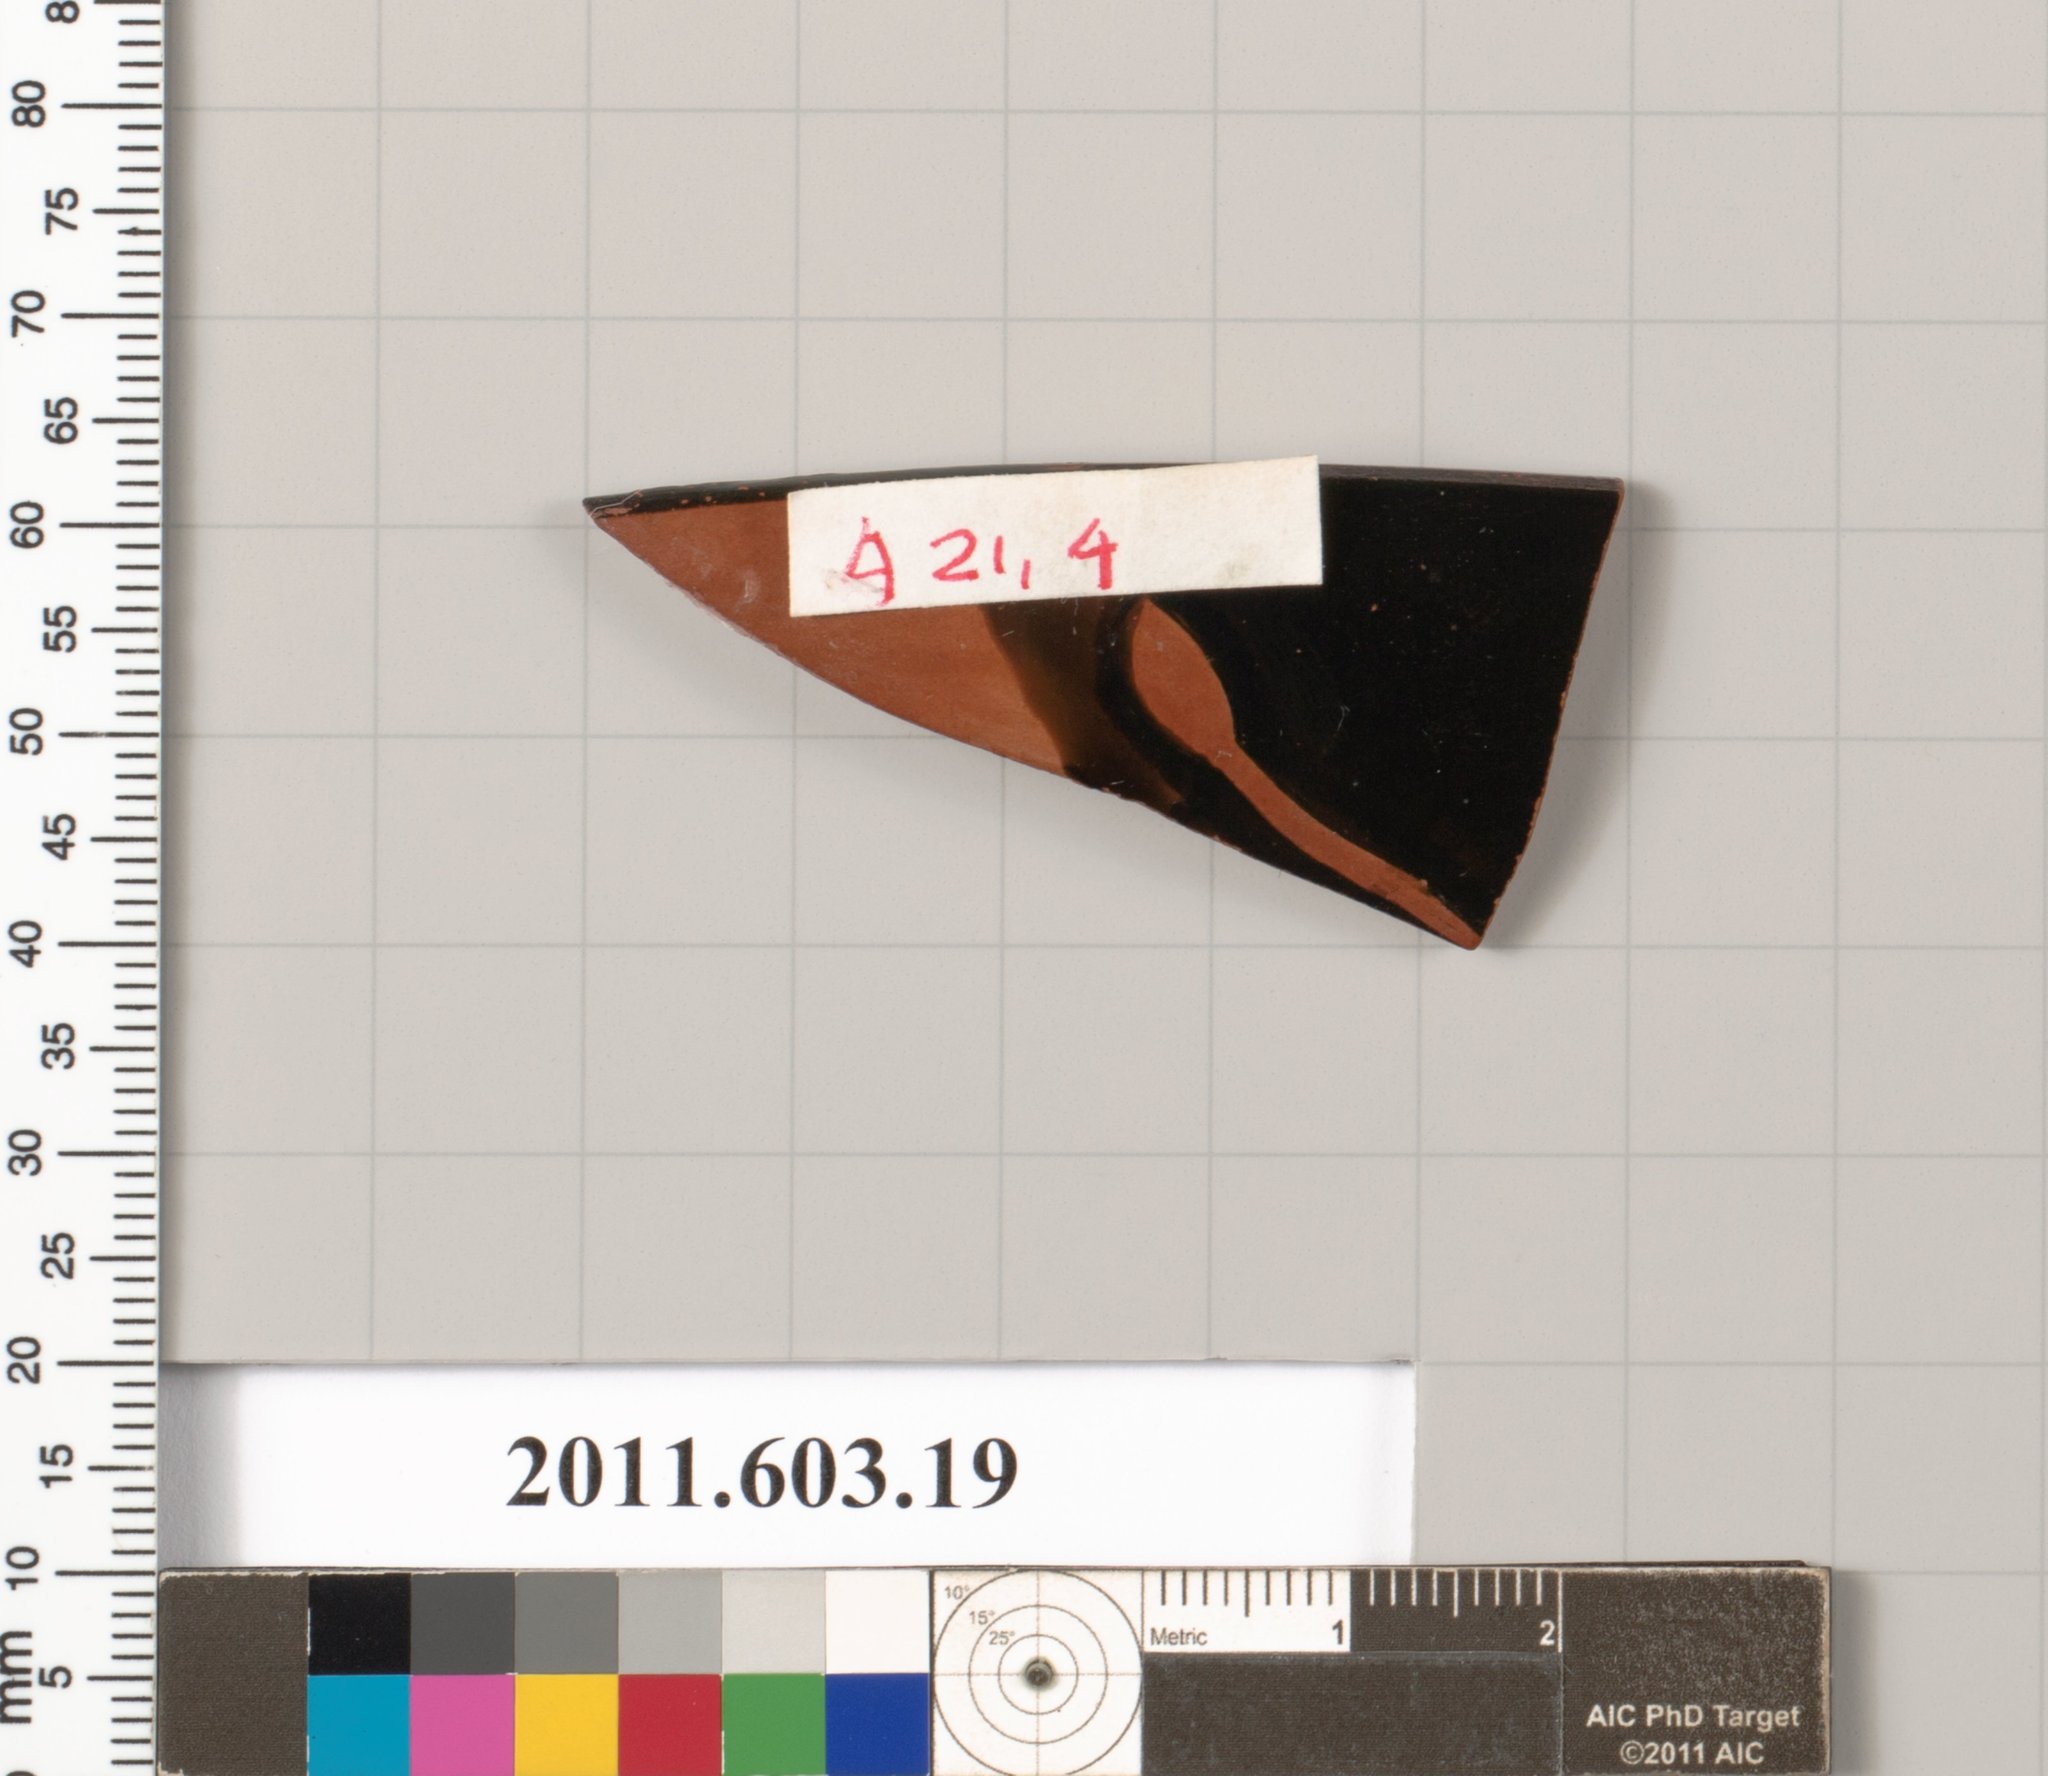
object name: kylix fragment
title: Rim fragment of a terracotta kylix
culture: greek, attic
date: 534-468 BCE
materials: terracotta